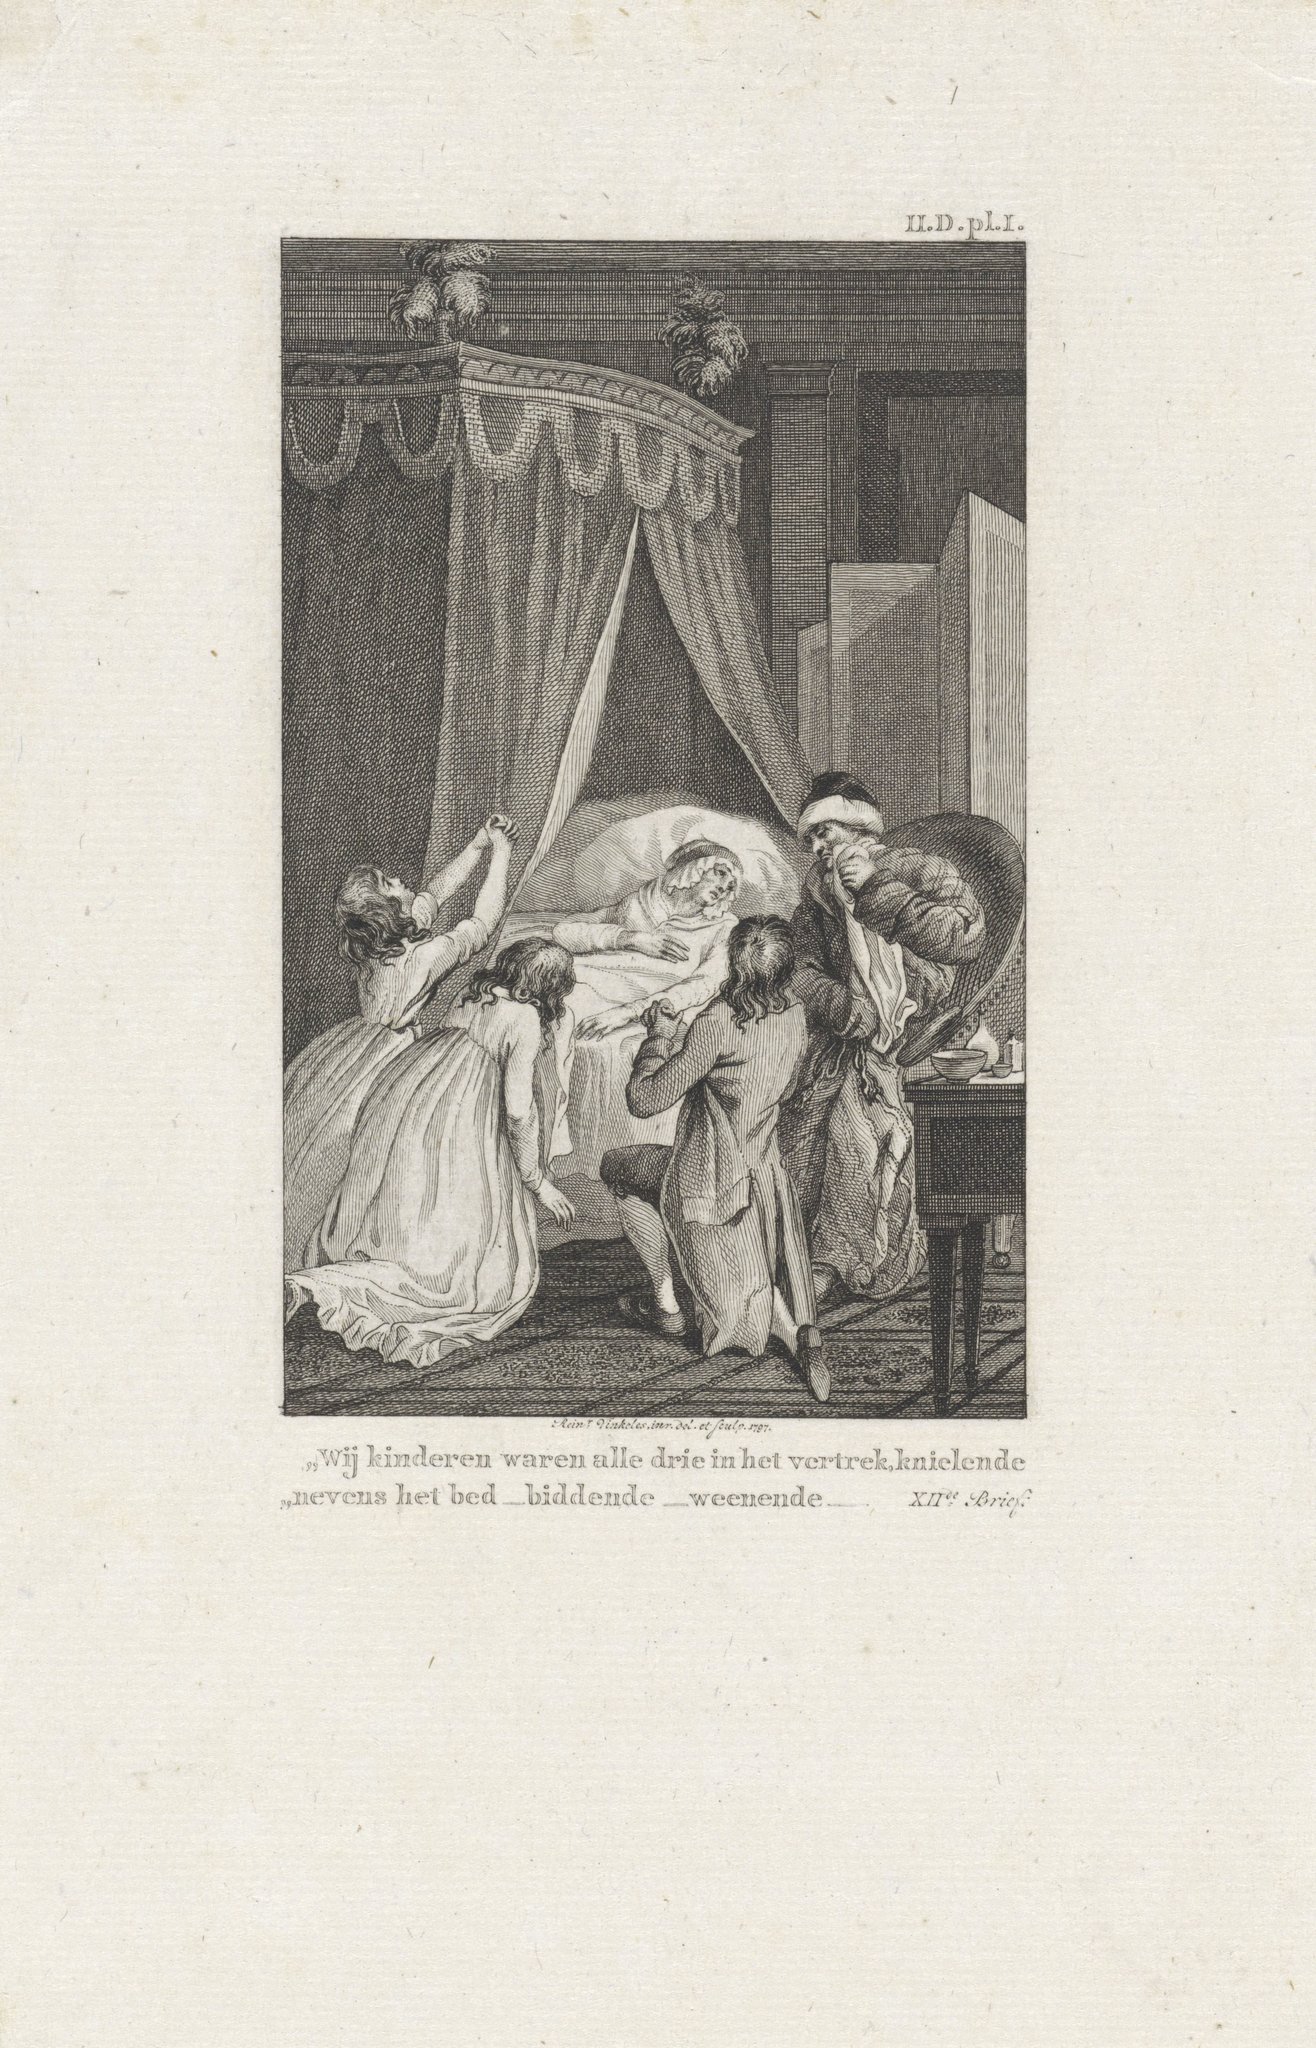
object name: print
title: Gezin rond het ziekbed van de moeder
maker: reinier vinkeles (i)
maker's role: draughtsman, print maker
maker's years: 1741-1816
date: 1797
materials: paper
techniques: engraving, etching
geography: amsterdam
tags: sick-bed, one person praying, visiting the sick; sick person together with others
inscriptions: collector's mark: Lugt 240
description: Illustratie uit: Richardson, Samuel. Geschiedenis van Karel Grandison. Amsterdam: Johannes Allart, 1797-1802.